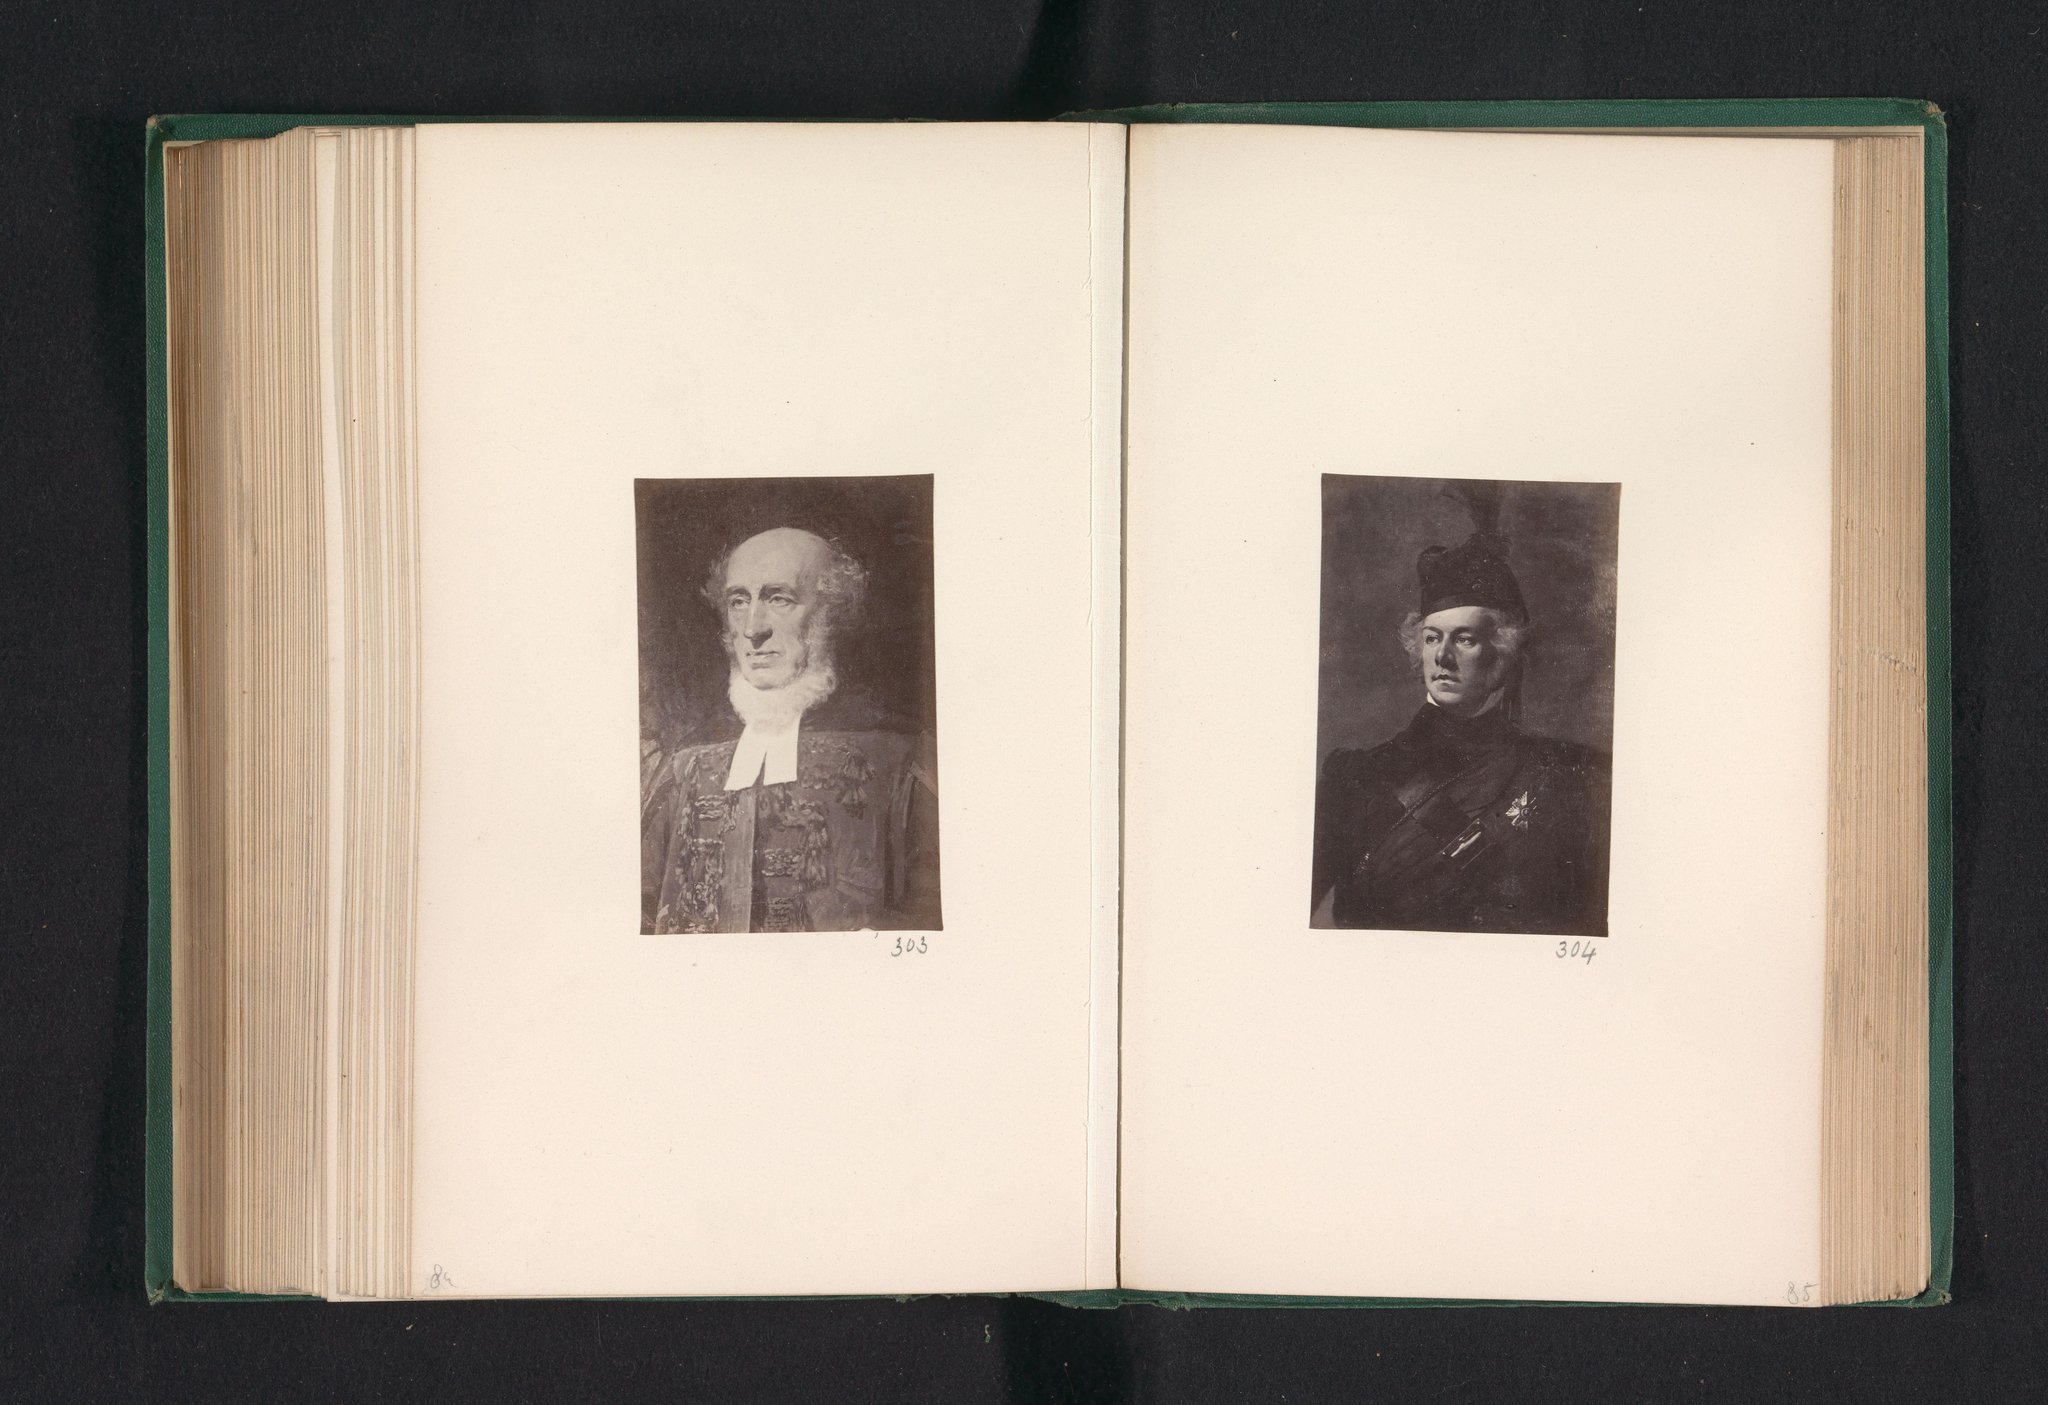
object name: photograph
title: Fotoreproductie van een schilderij, voorstellende een portret van Alexander Hill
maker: thomas annan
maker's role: fotograaf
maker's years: 1829-1887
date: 1863-1868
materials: photographic support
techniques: albumen print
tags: historical persons (portraits and scenes from the life) (+ (full) bust portrait)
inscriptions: number: ‘303’